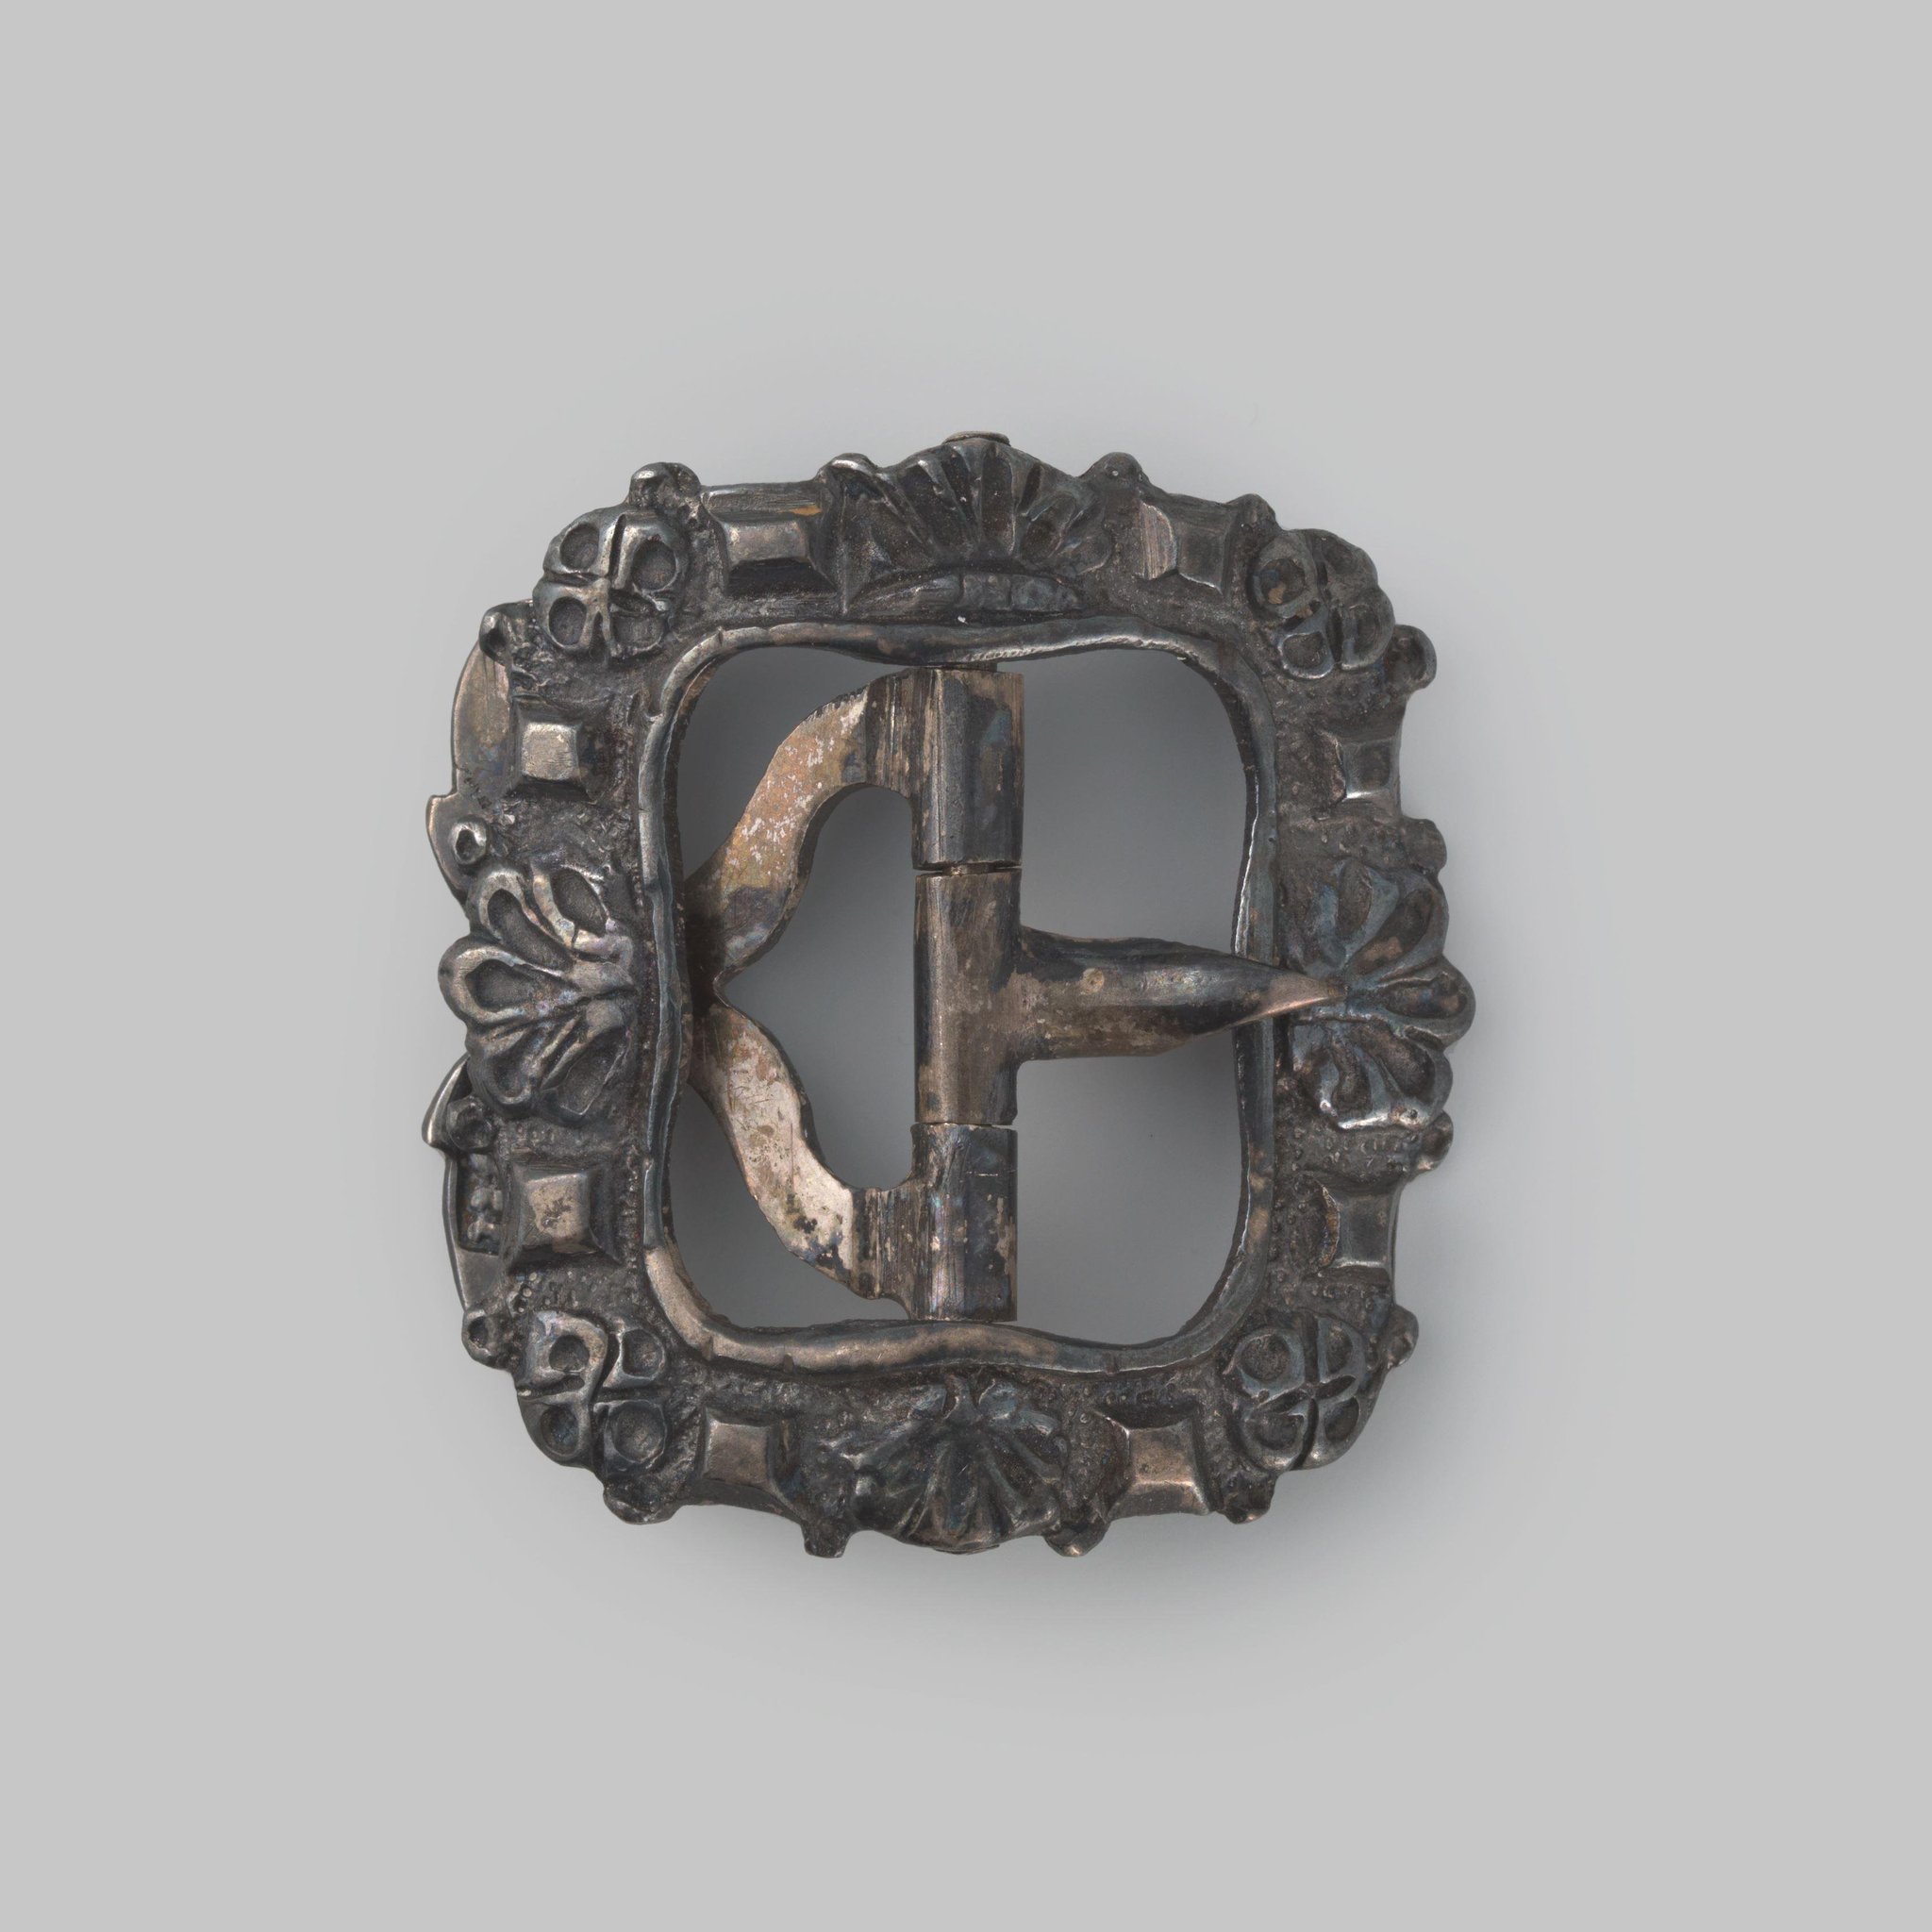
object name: shoe buckle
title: Schoengesp, vierkant, versierd met palmetten, bloemen en vierkanten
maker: martinus van der pol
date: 1773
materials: silver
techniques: casting, metalworking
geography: middelburg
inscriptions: maker's mark, date letter: ‘K’, town mark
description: Schoengesp van zilver, vierkant, afwisselend versierd met palmetten, bloemen en vierkanten. De schanierende sluiting met één pin is eveneens van zilver.